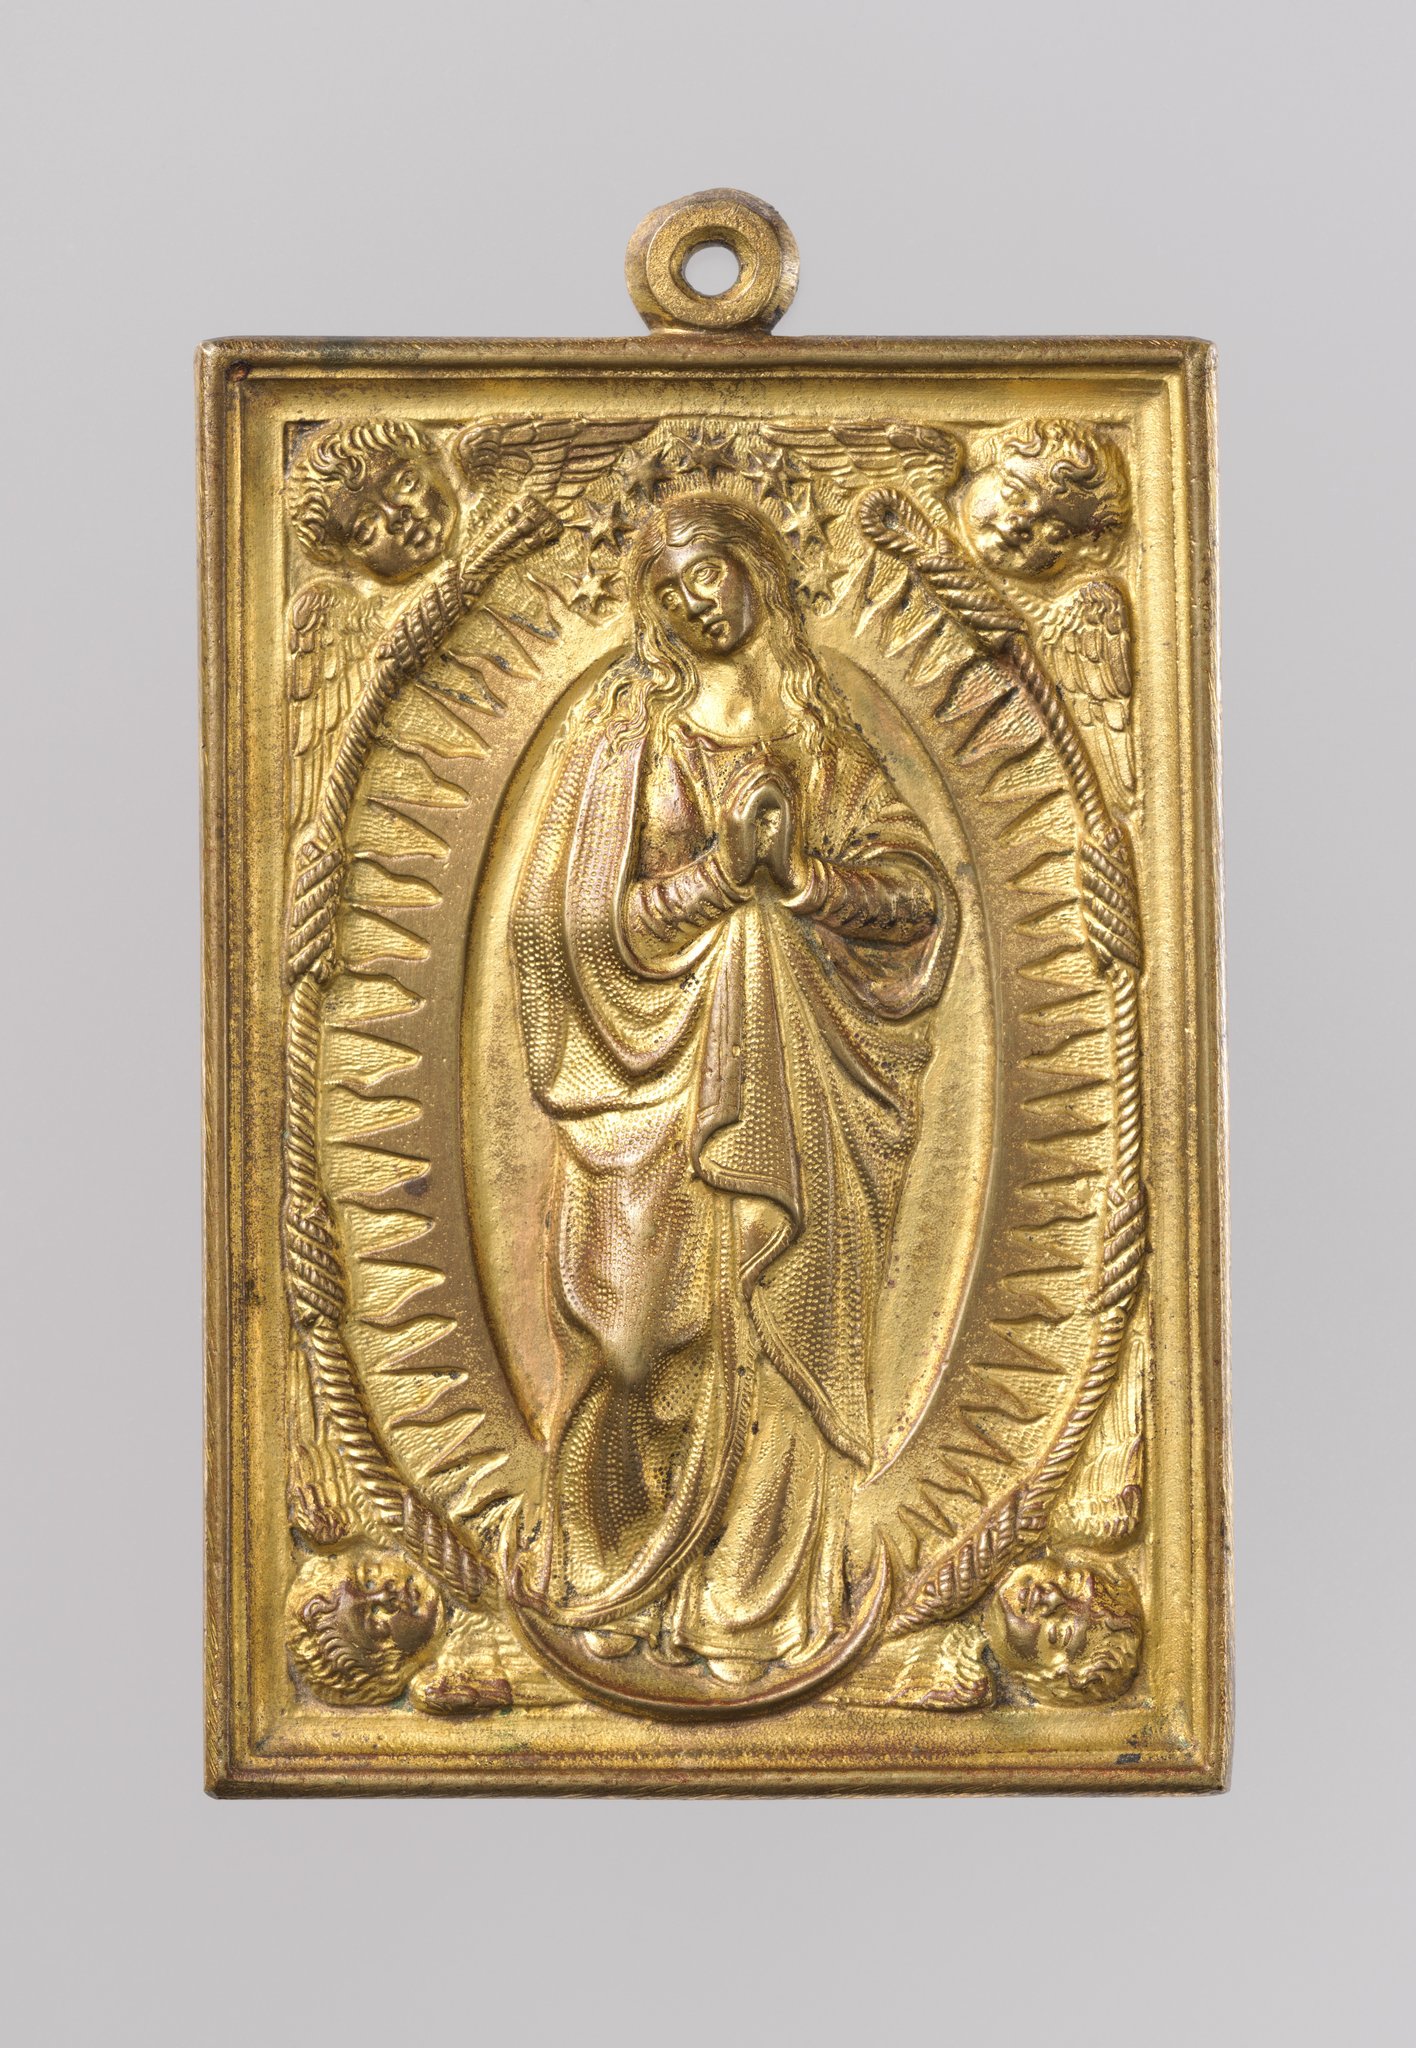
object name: plaquette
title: Virgin of the Immaculate Conception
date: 1600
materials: gilt bronze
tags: virgin mary